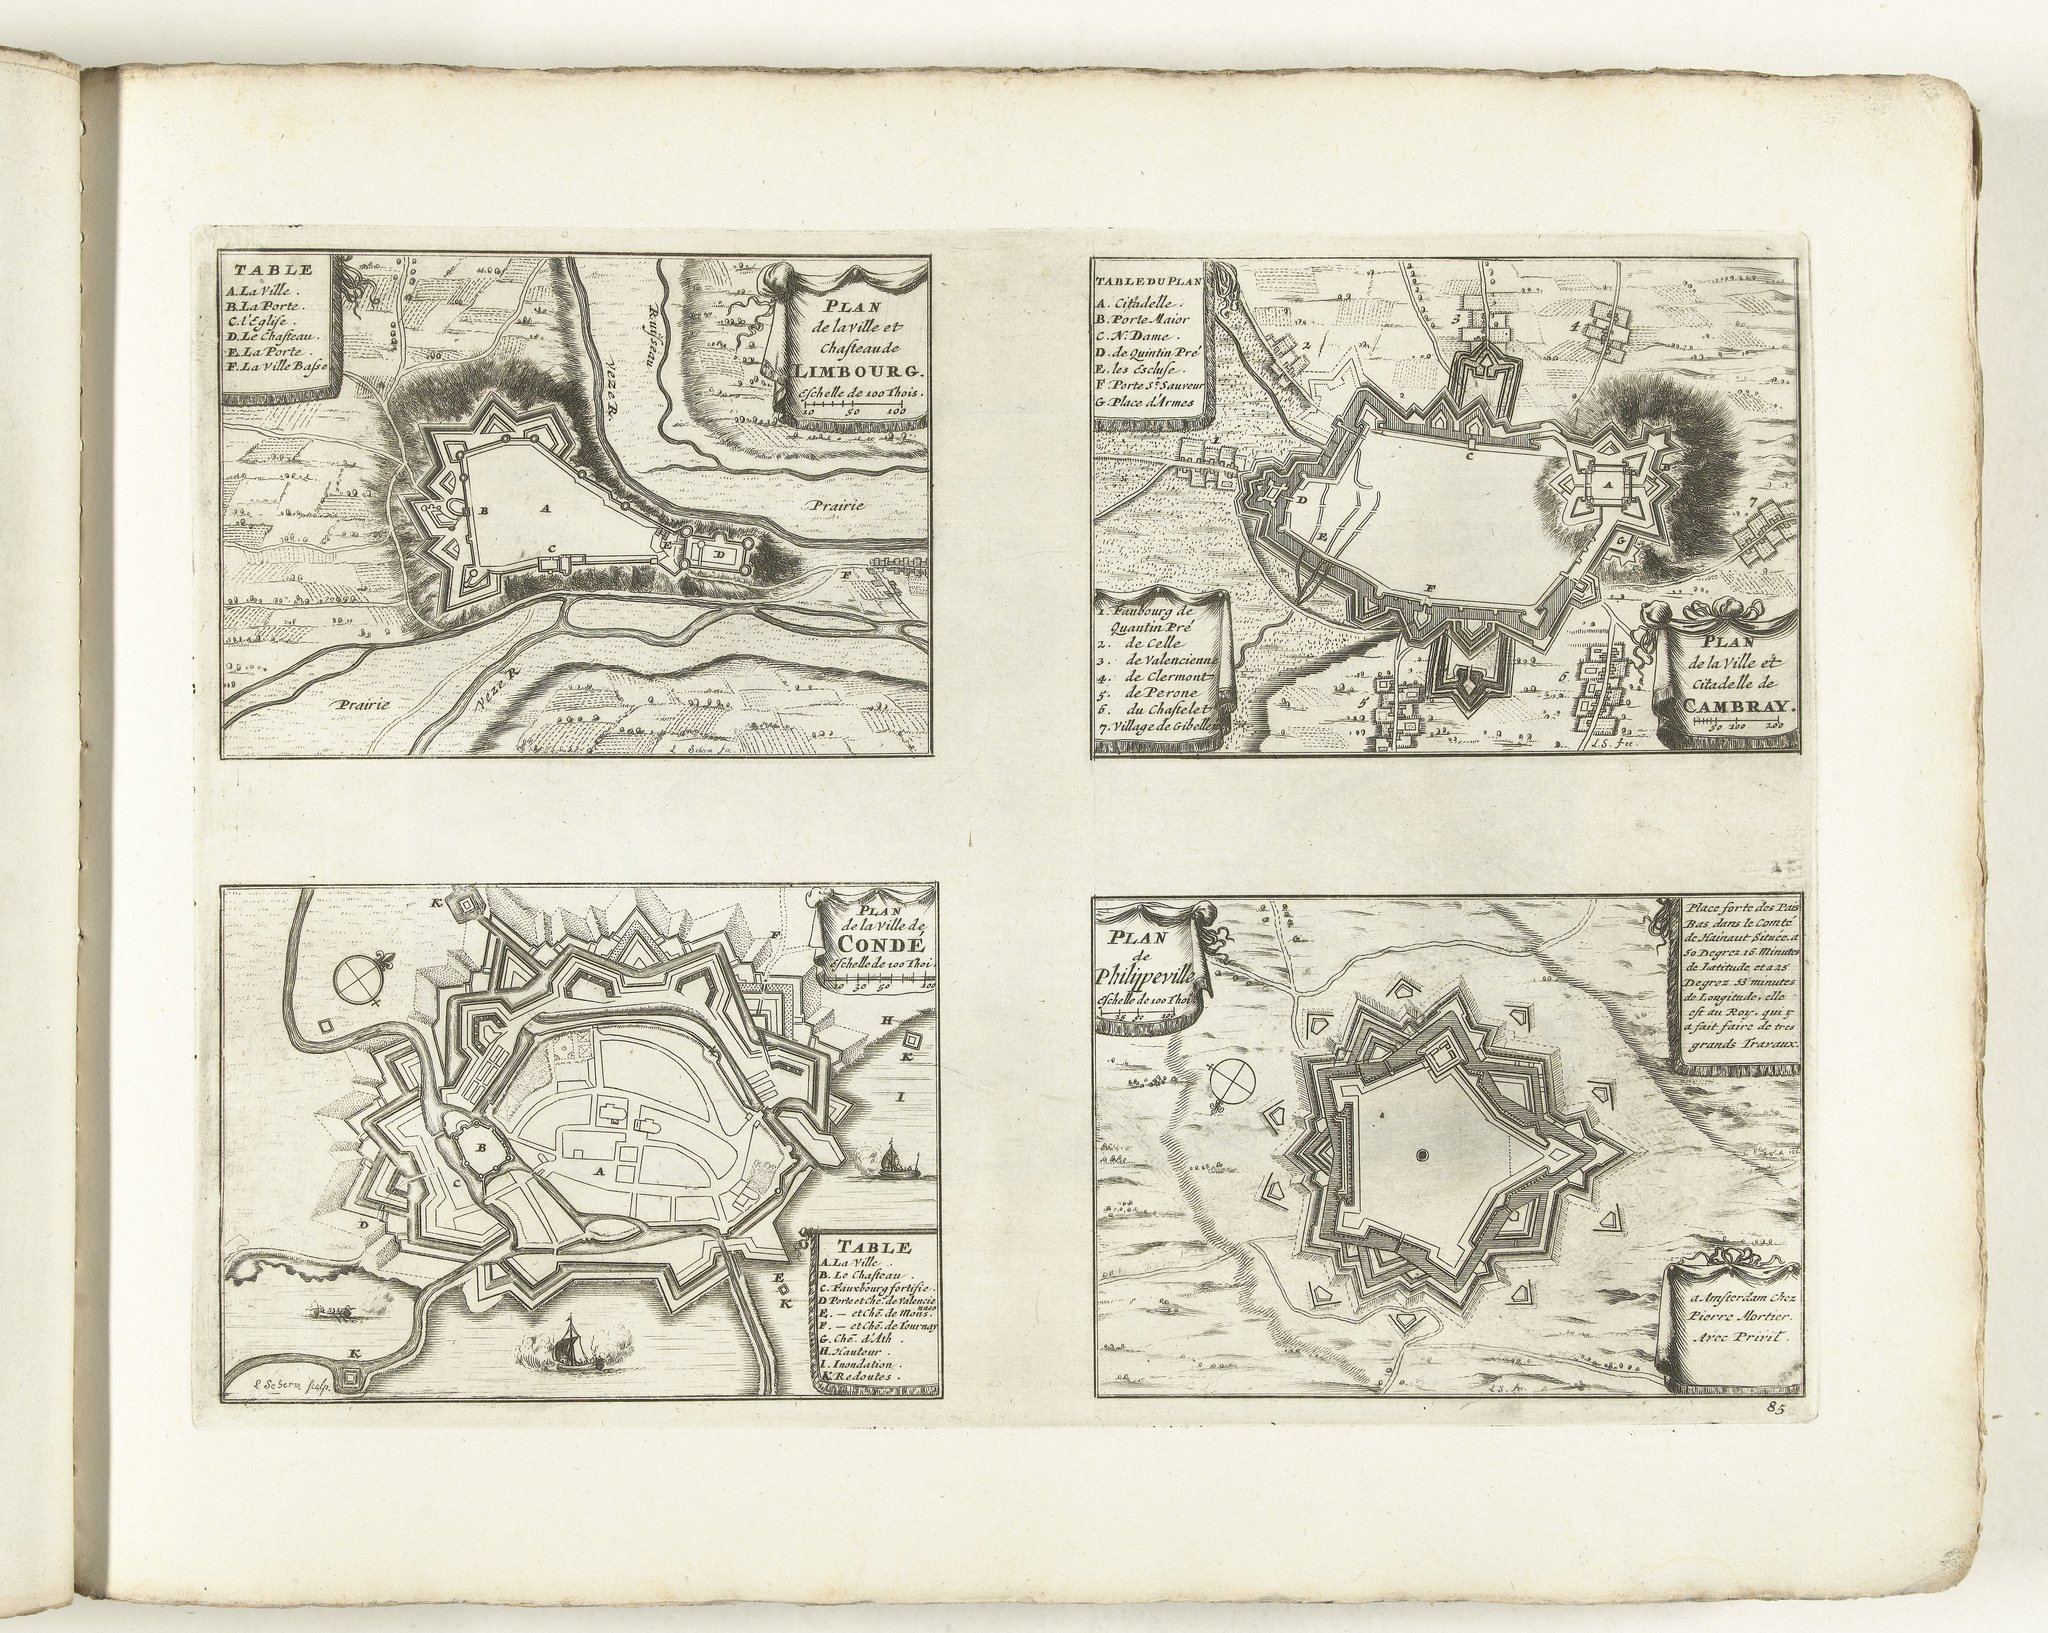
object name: print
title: Limbourg / Cambray / Condé / Philippeville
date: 1702-1703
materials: paper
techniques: engraving, etching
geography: northern netherlands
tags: fortress, maps of cities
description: Blad met vier plattegronden van de versterkingen om de steden Limbourg, Cambrai (Kamerijk), Condé en Philippeville. Plaat nr. 85 in het prentwerk bestaande in totaal uit 276 genummerde platen van vermaarde sterke steden en vestingen in het kader van de Spaanse Successieoorlog. Voor het merendeel zijn deze platen gekopieerd naar de anonieme Franse platen: in Les forces de l'Europe en in: Le theatre de la guerre, dans les Pays-Bas, beide oorspronkelijk uitgegeven door Nicolas de Fer te Parijs (1693-1697) in het kader van de Negenjarige Oorlog. Titels en opschriften in de plaat in het Frans.